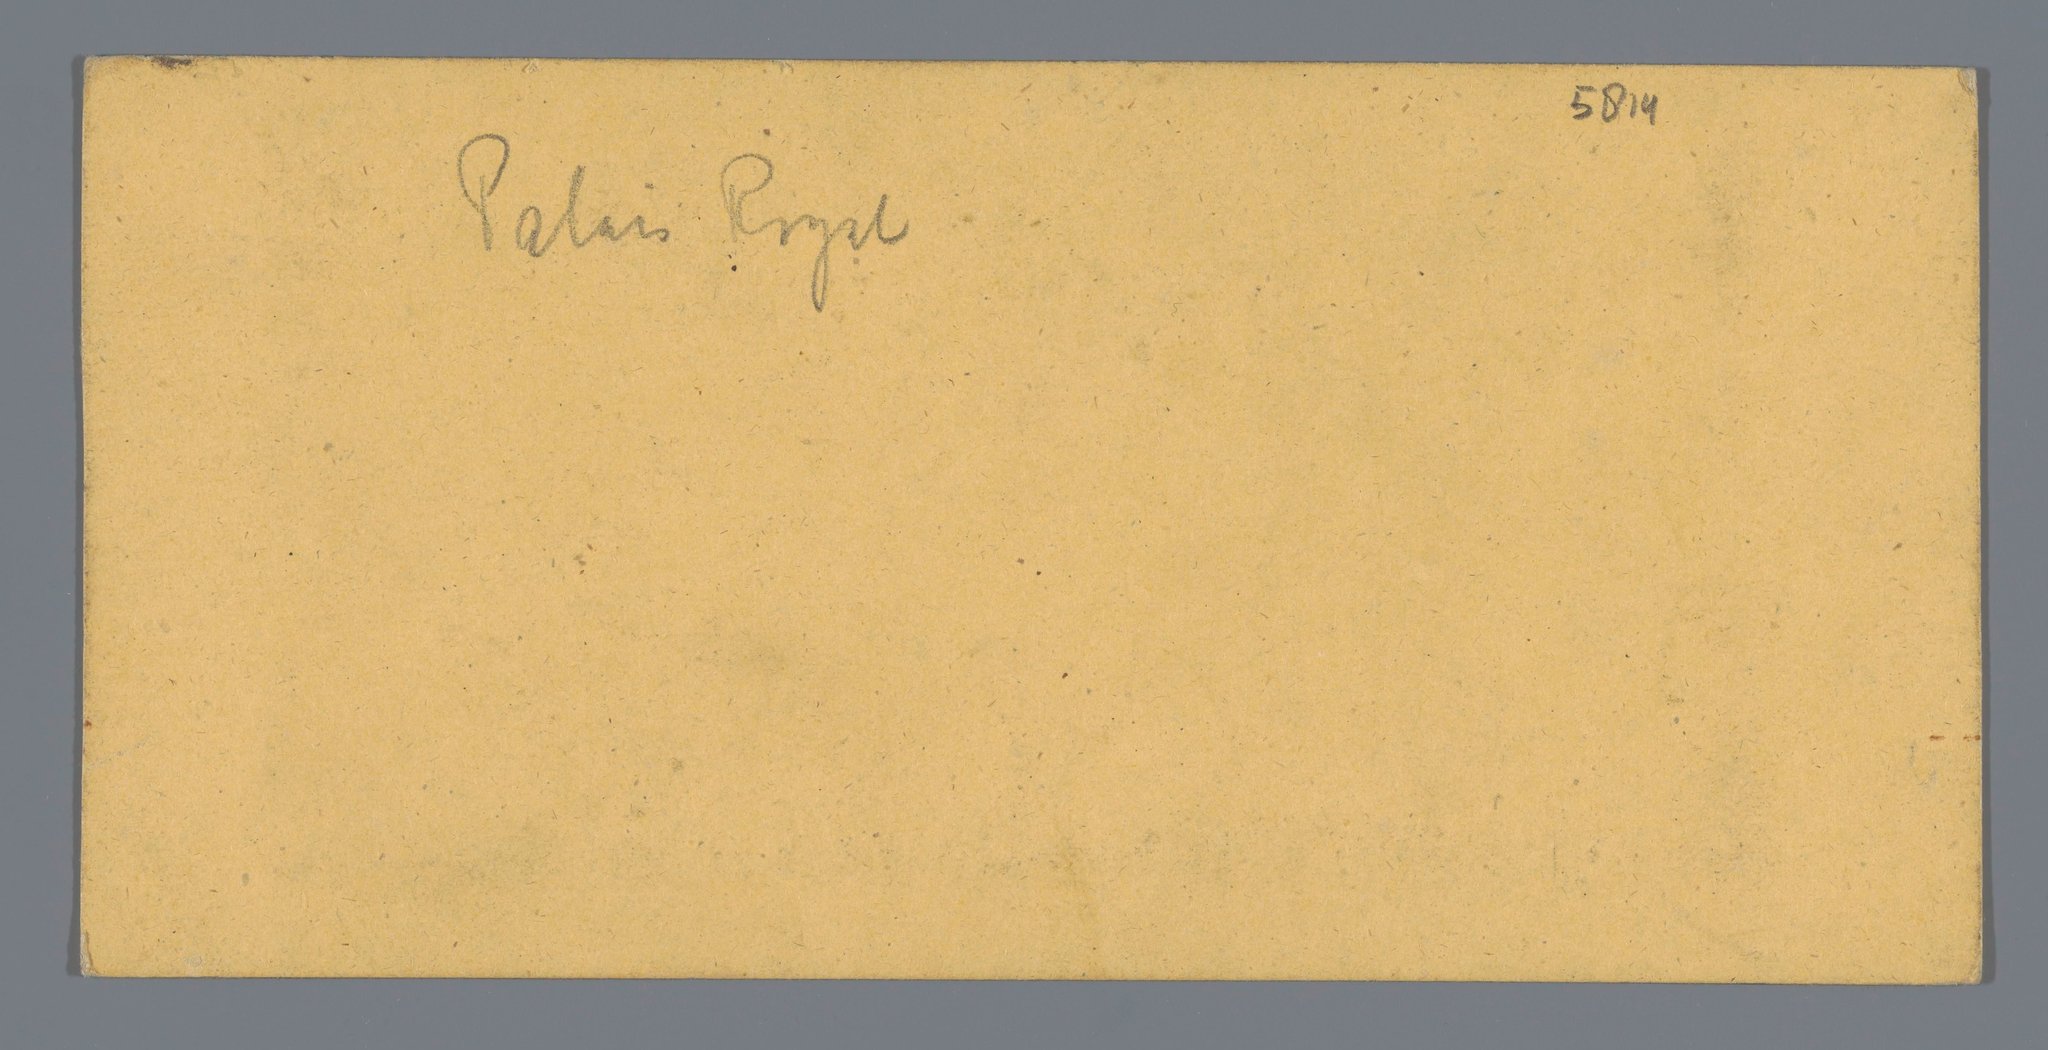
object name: stereograph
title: Gezicht op het Palais-Royal in Parijs vanuit de paleistuin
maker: Anonymous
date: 1850-1880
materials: cardboard, photographic support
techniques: albumen print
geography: paris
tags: garden, palace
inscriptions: inscription: ‘Palais Royal’